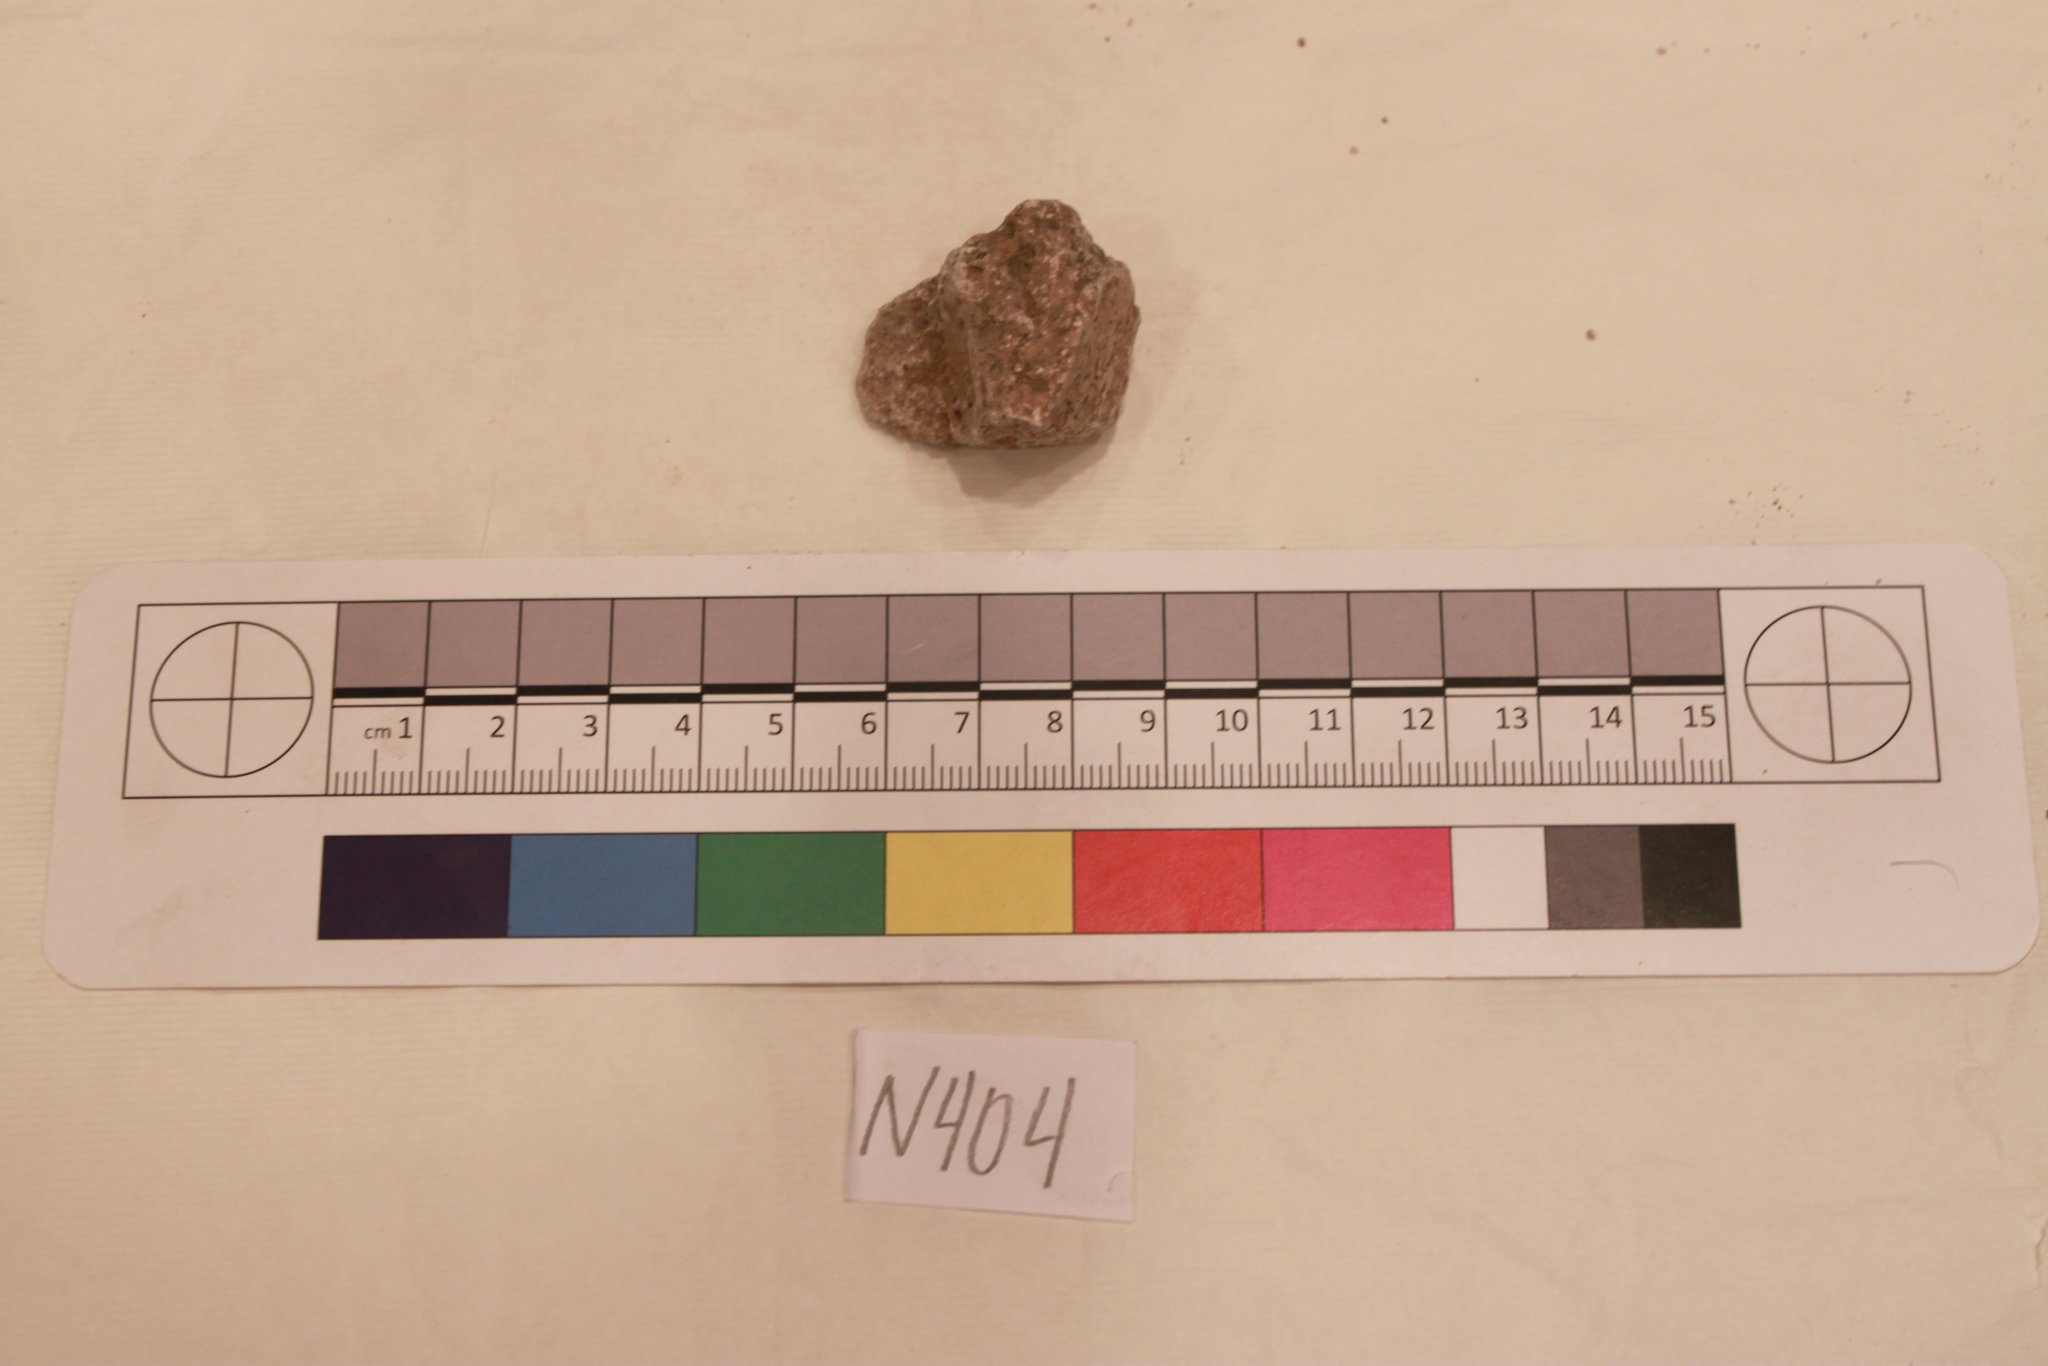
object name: fragment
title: Stucco Fragment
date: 701-1200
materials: plaster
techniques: carving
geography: iran